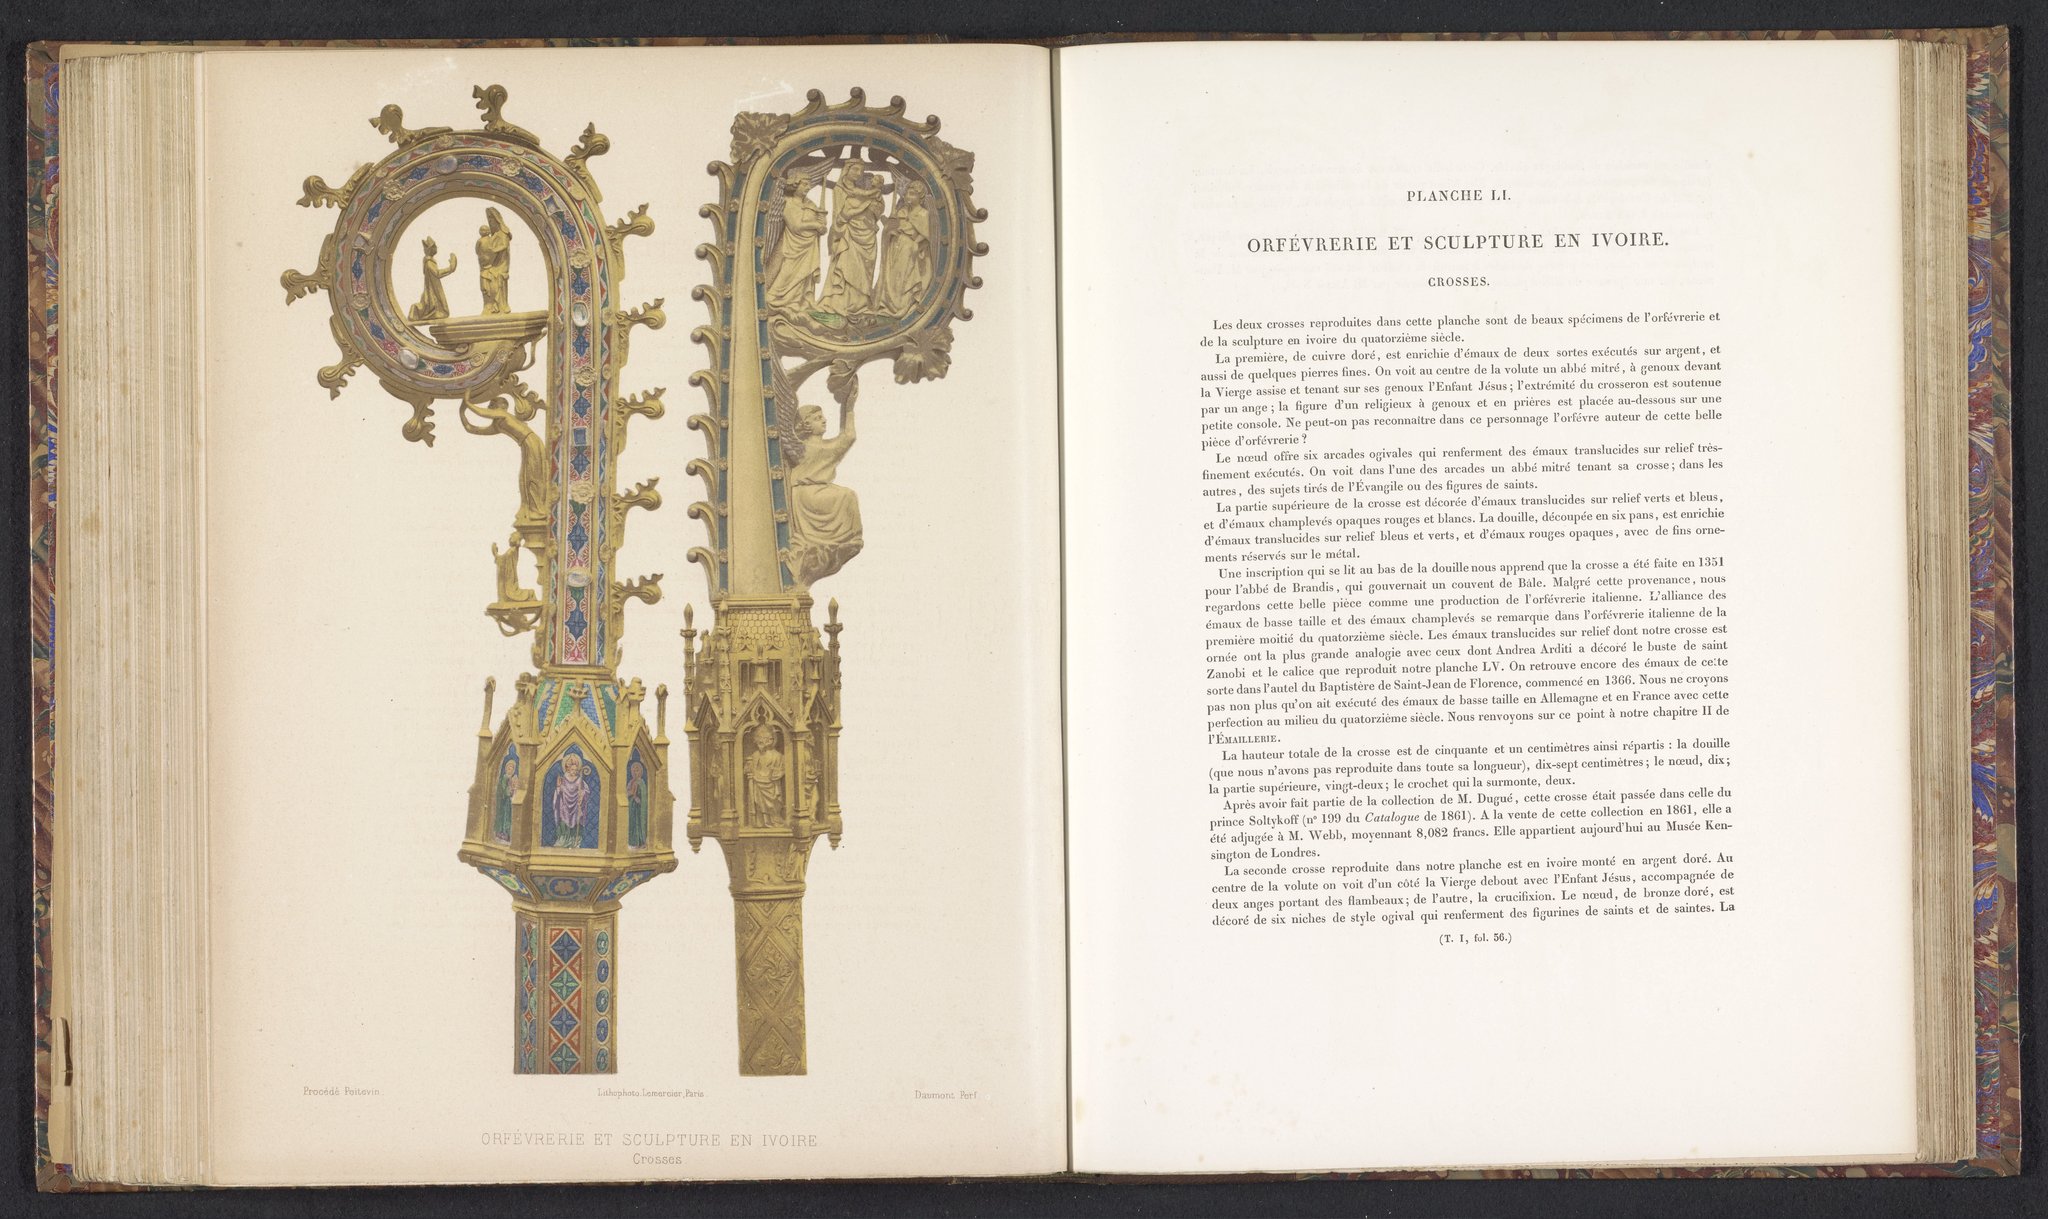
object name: page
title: Orfévrerie et sculpture en ivoire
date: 1859-1864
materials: paper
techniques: photolithography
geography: paris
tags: insignia of bishop, e.g. mitre, crozier